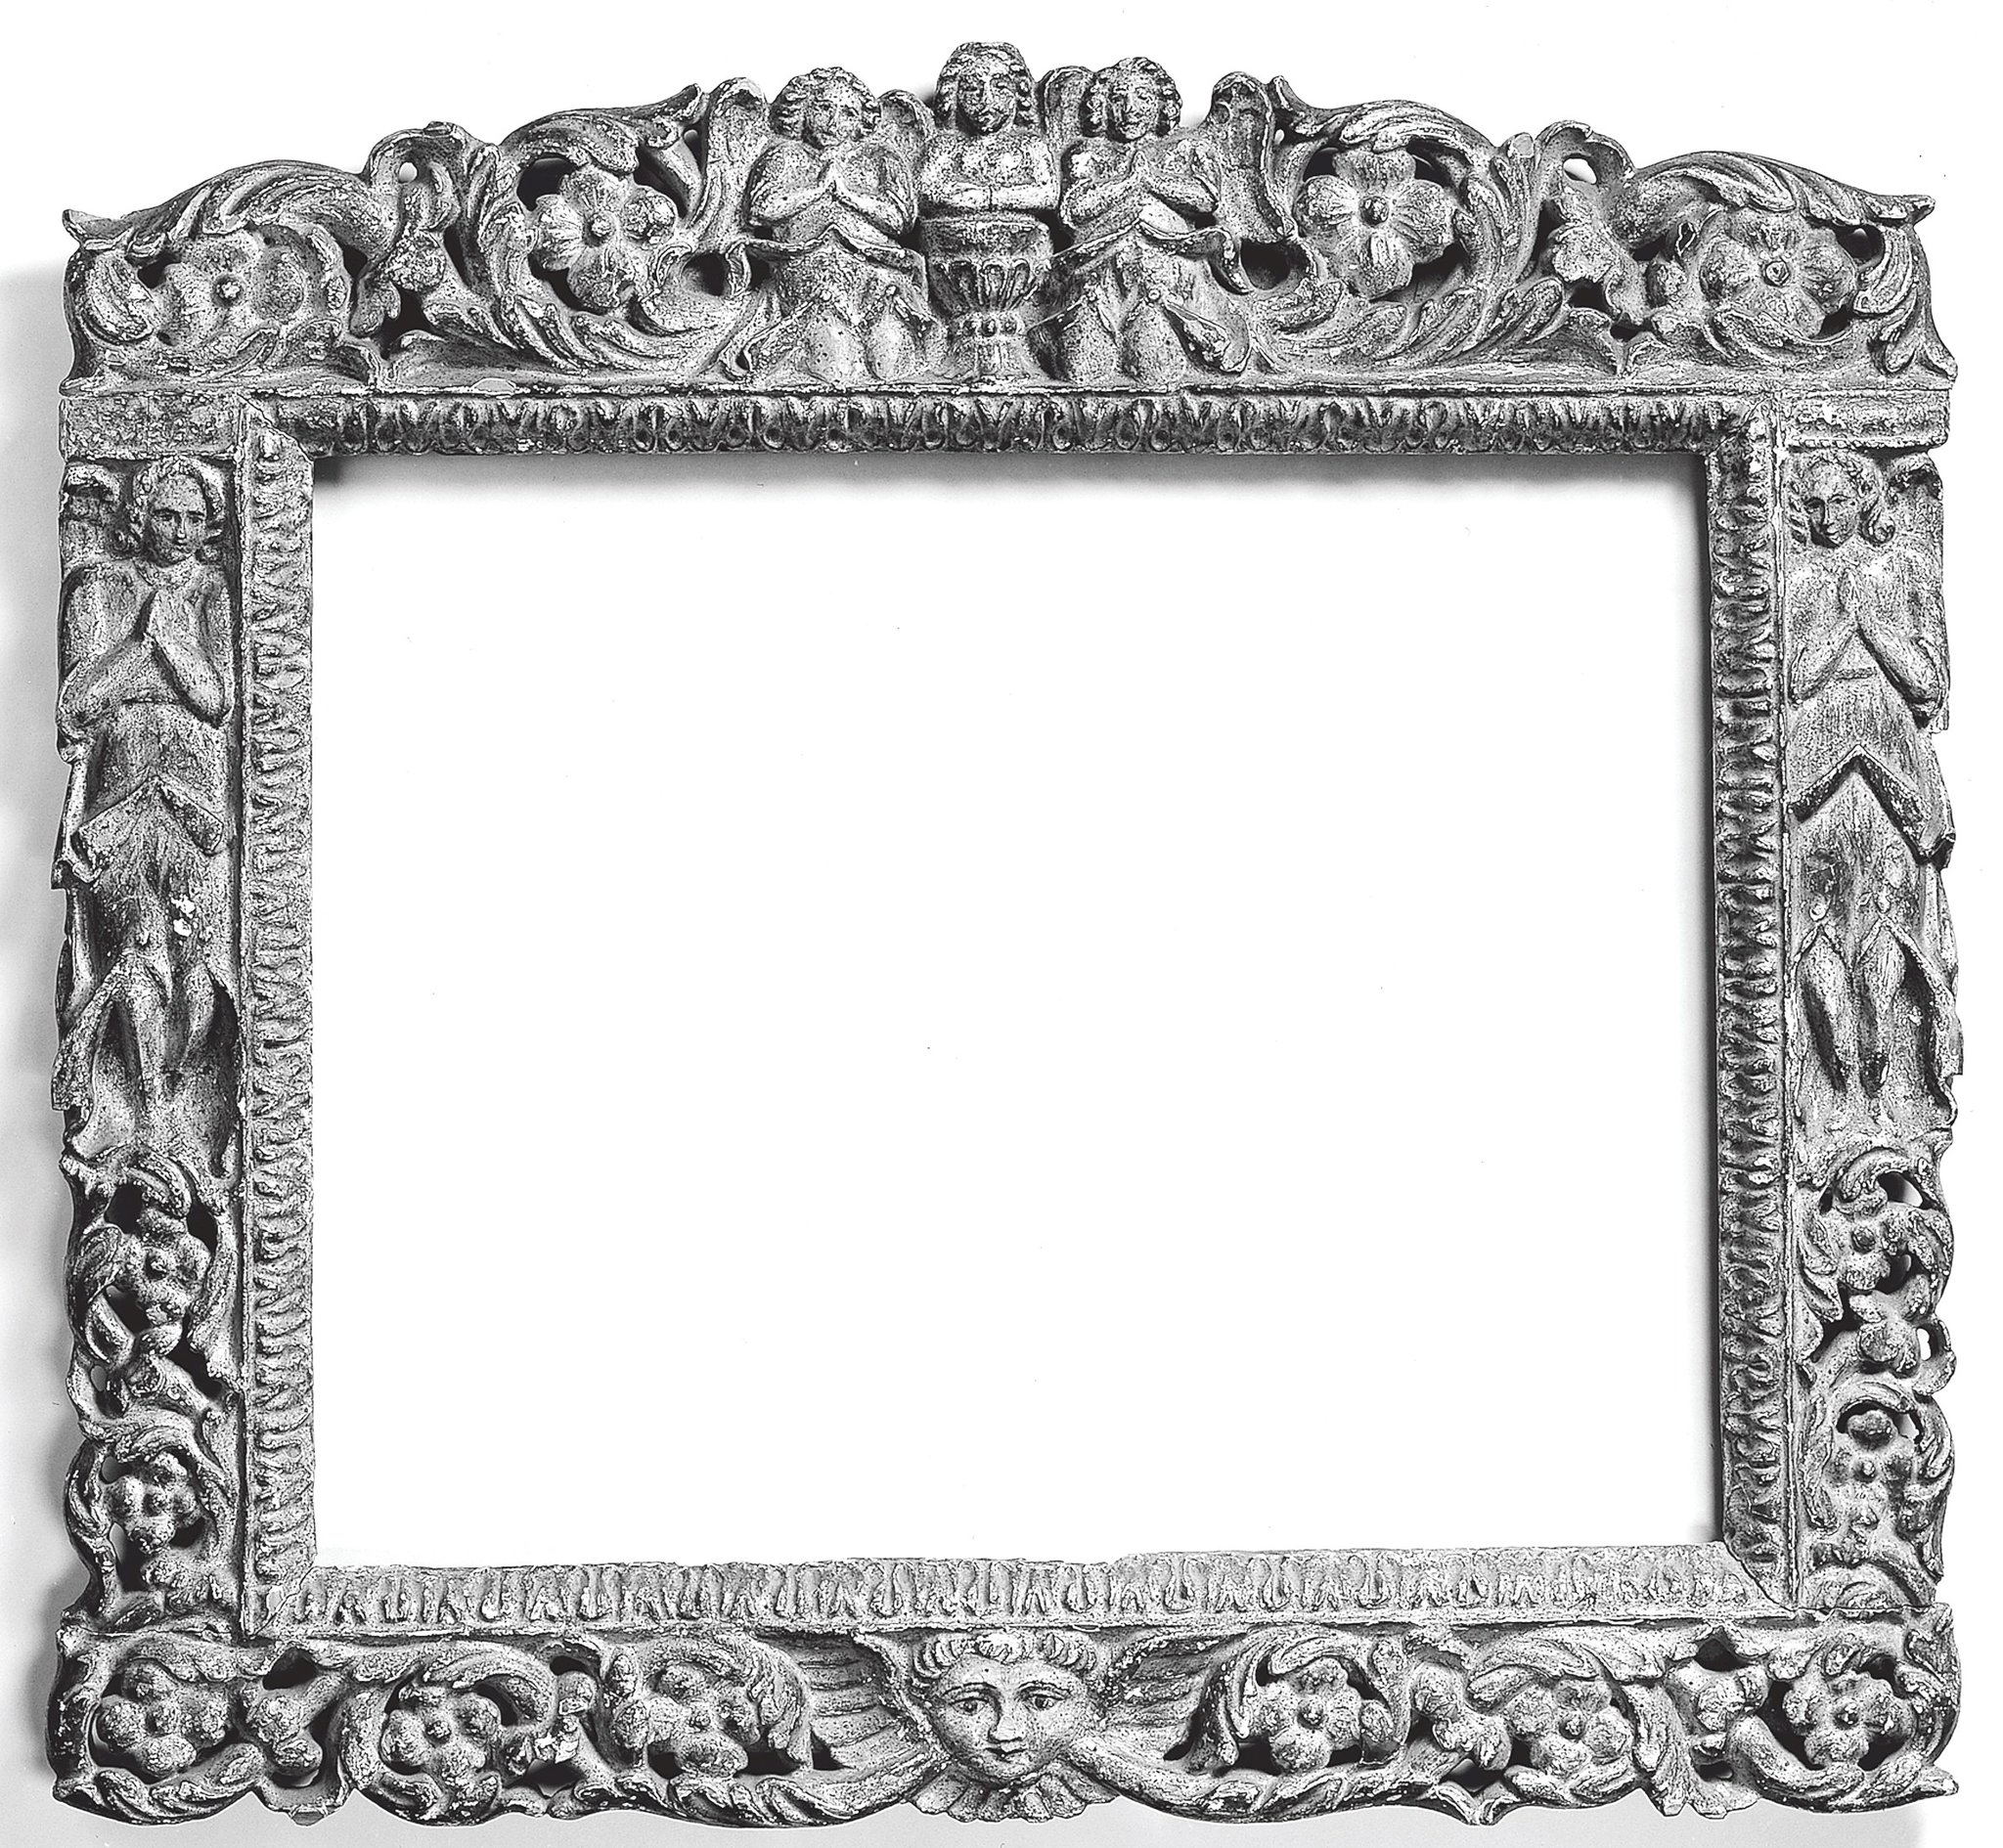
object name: frame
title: Corpus frame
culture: american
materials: wood